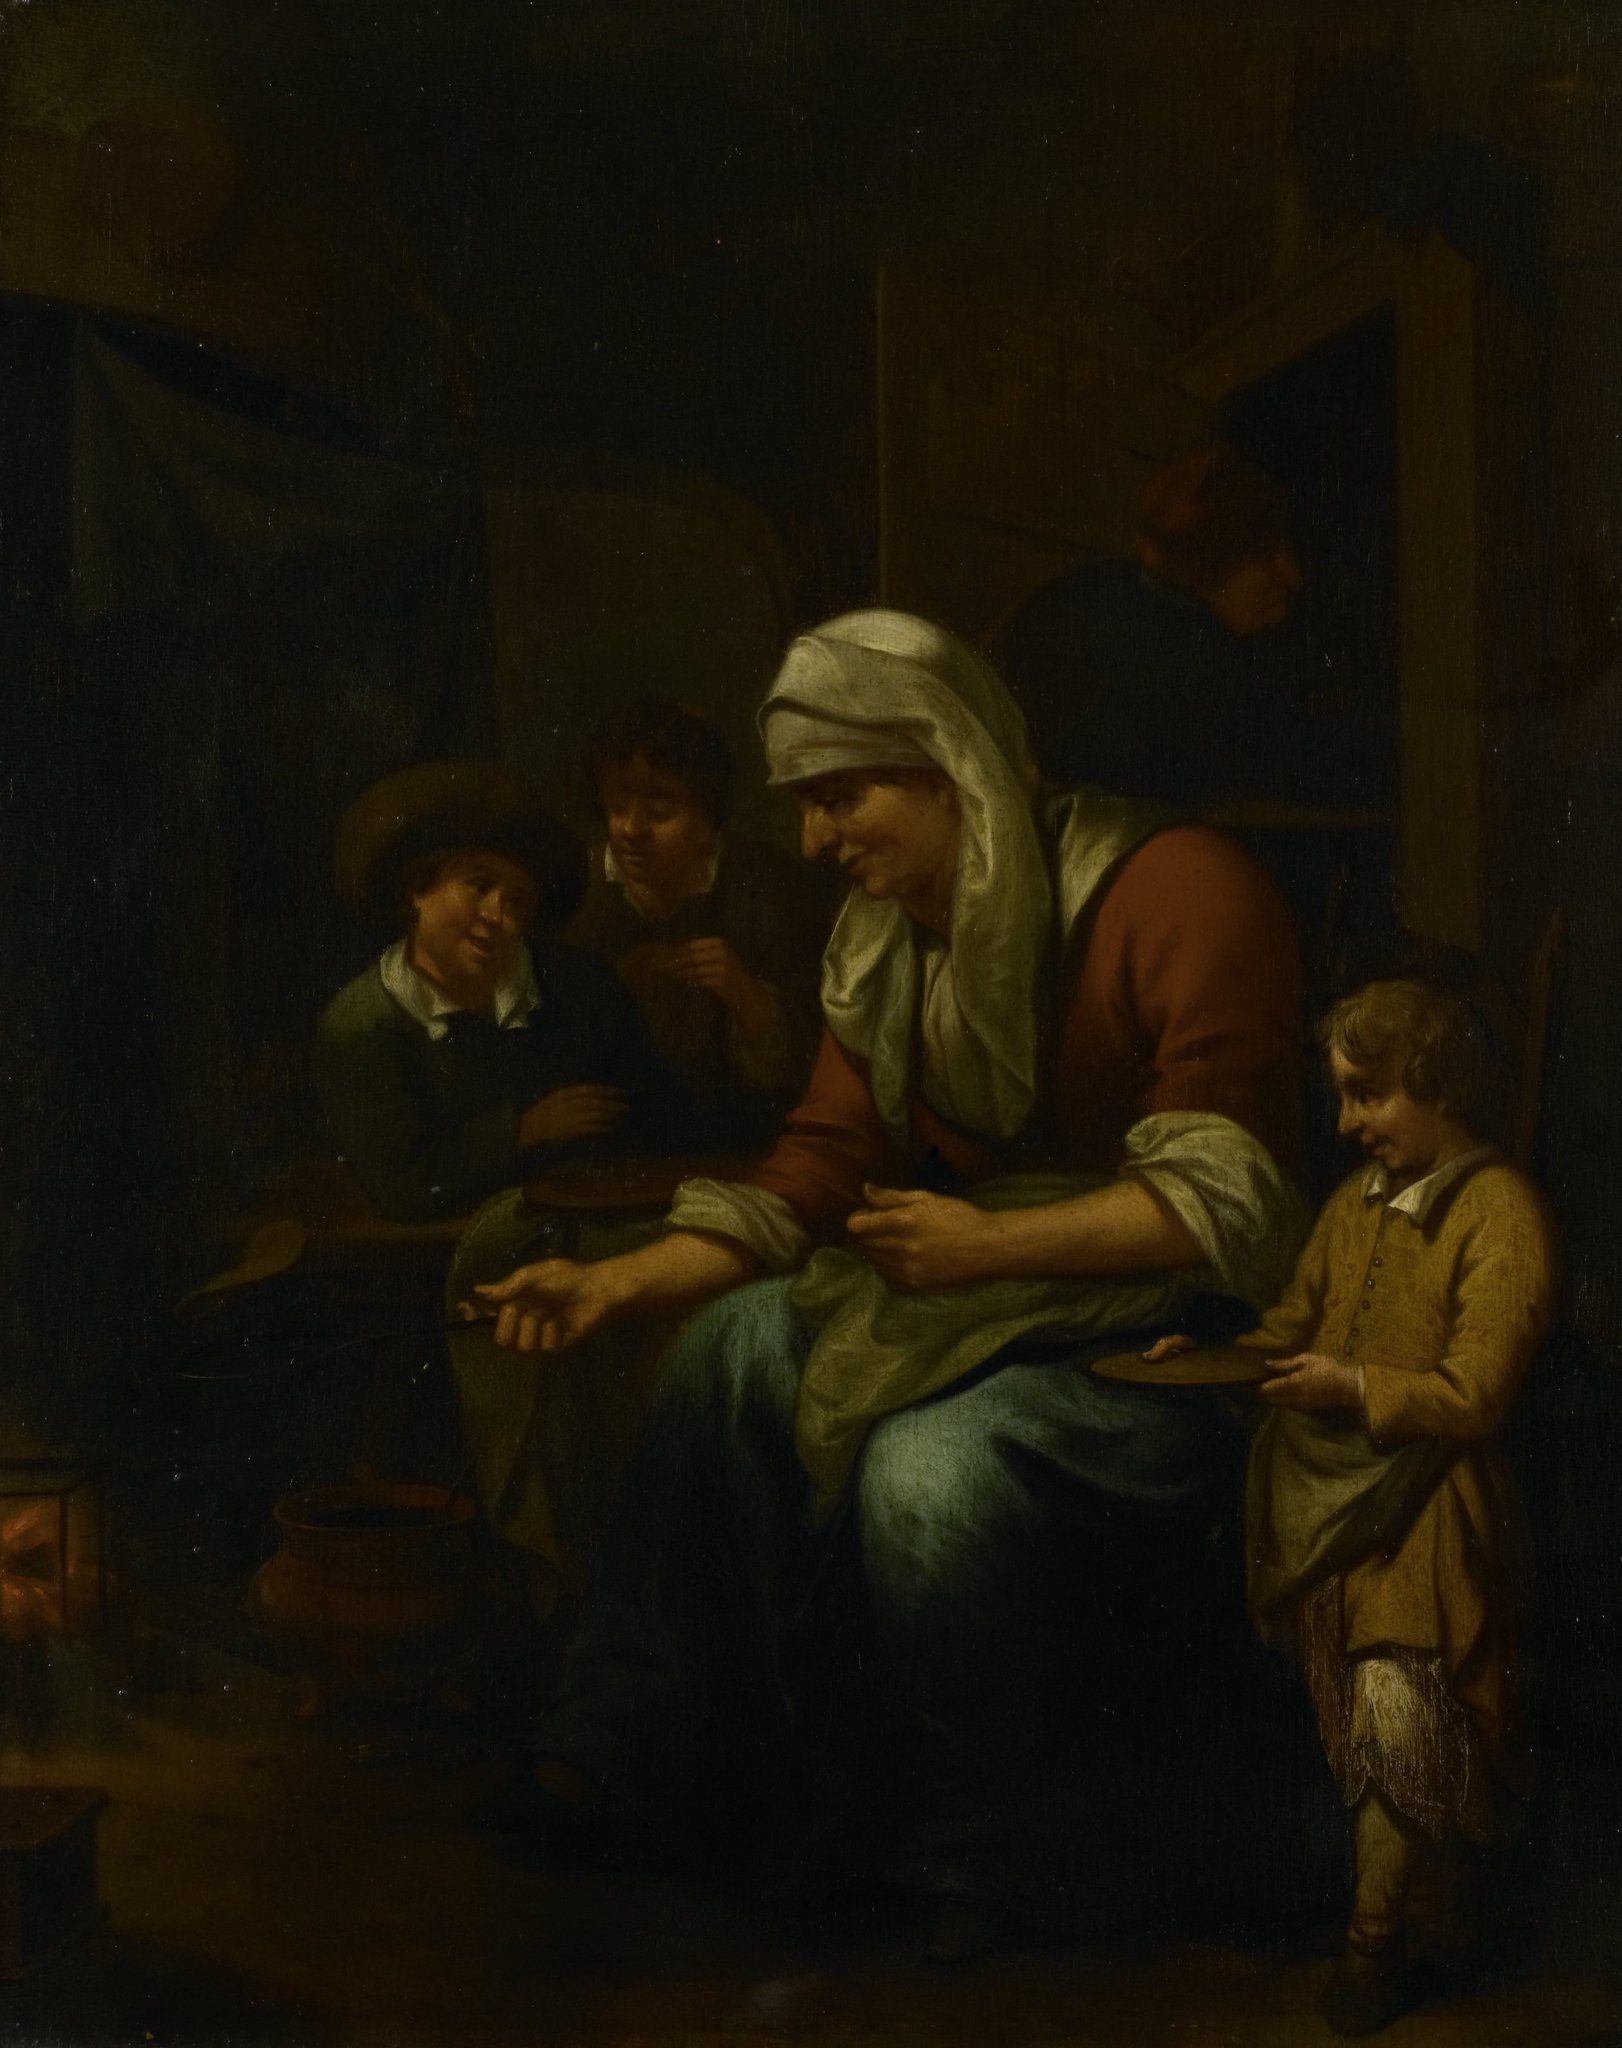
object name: painting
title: Woman making pancakes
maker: bernardus van schijndel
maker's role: painter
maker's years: 1647-1709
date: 1670-1709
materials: oil, panel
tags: pancakes, cooking food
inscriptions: signature: ‘BvS’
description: De pannenkoekenbakster. Zittend voor een vuur in een keuken bakt een vrouw pannenkoeken in een klein pannetje. Links en rechts wachten kinderen op een portie. Op de achtergrond staat een man voor een kast.